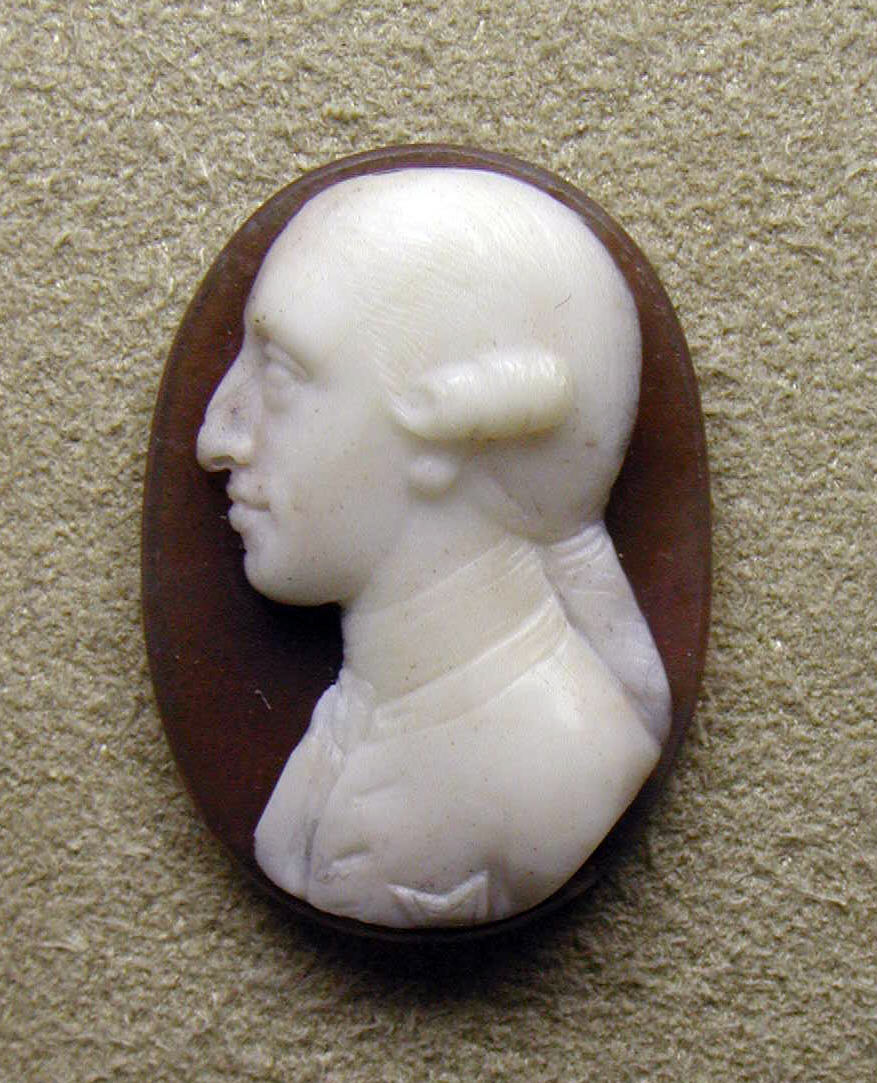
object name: cameo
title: Bust of a young man, possibly a Hapsburg Prince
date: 1790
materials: gemstone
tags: princes,profiles